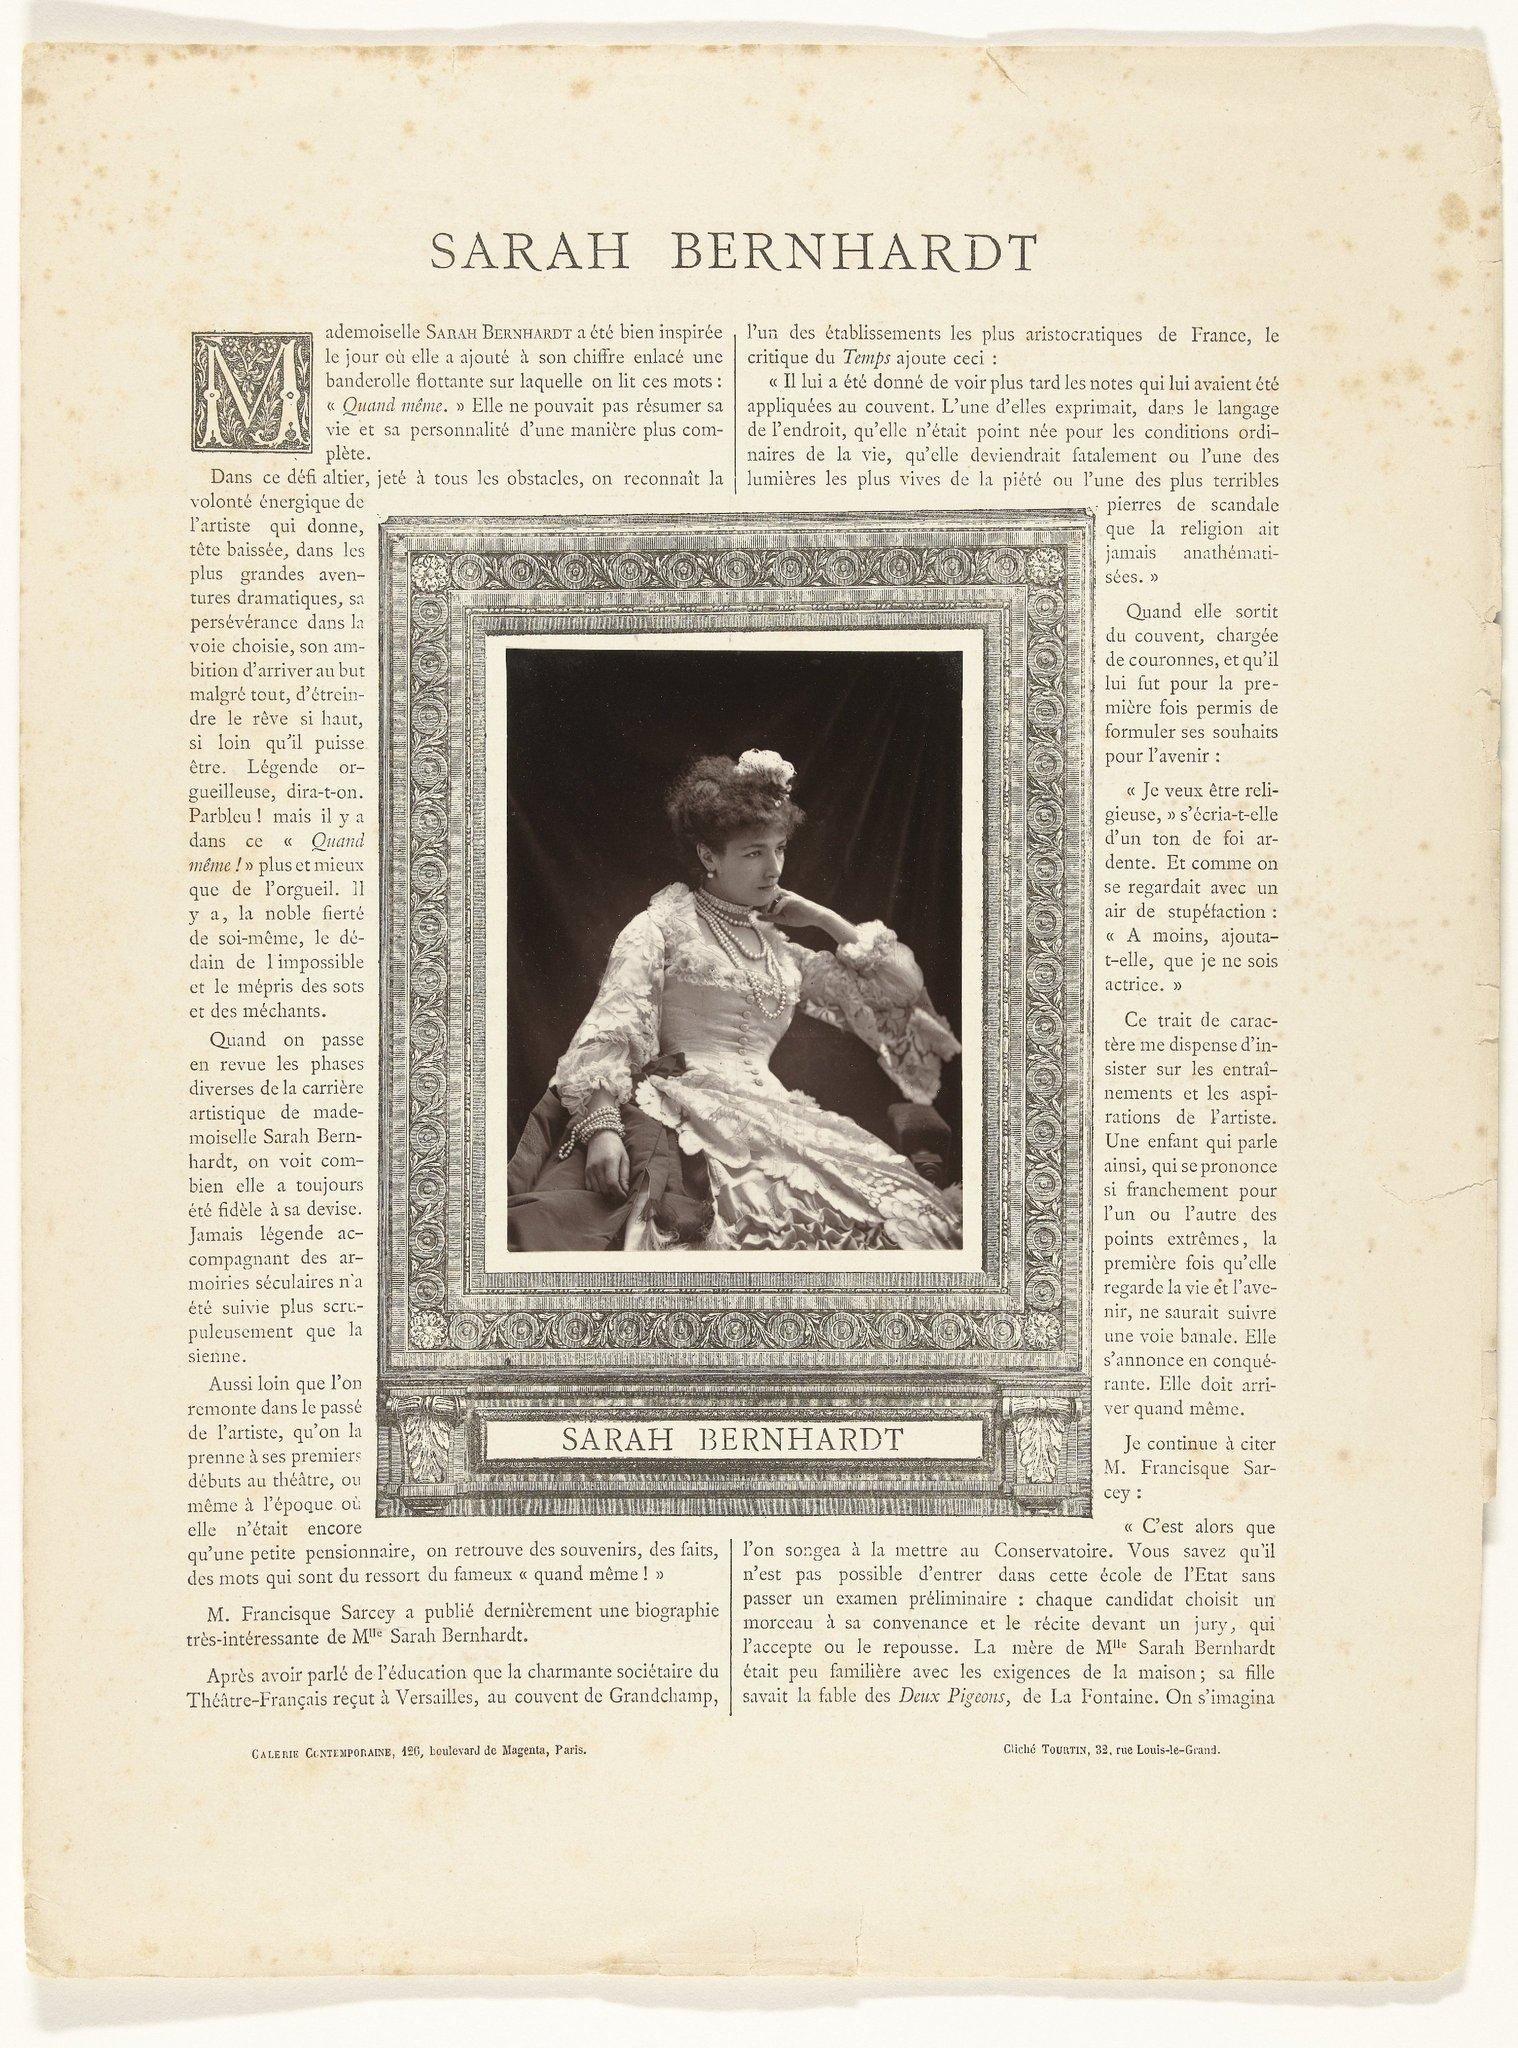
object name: photomechanical print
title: Portret van Sarah Bernhardt met biografie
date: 1877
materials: paper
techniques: letterpress printing, woodburytype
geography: france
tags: sarah bernhardt, portrait of actor, actress, paris